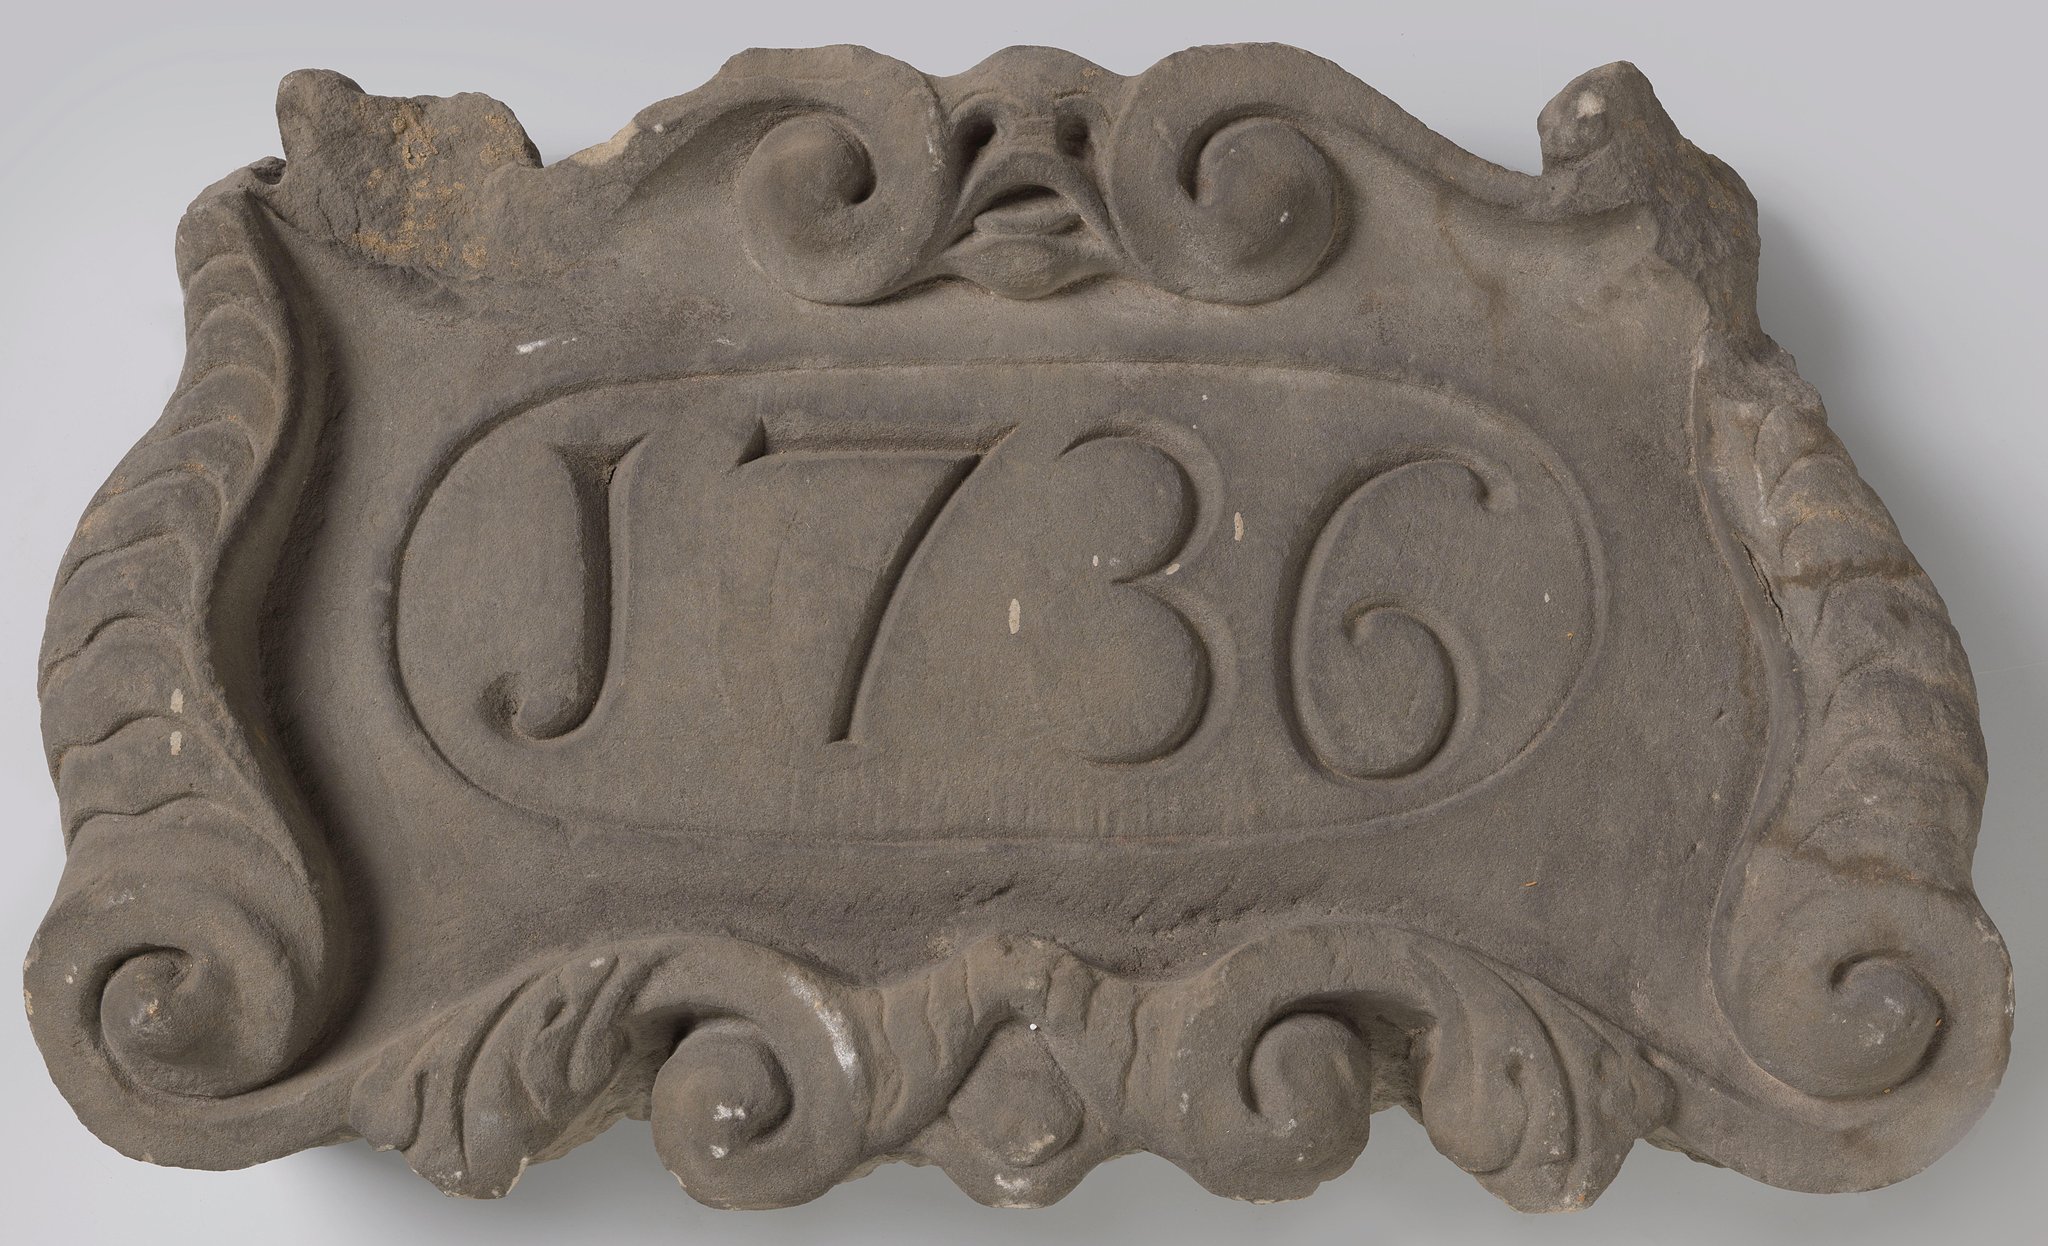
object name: gable stone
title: Gevelsteen met jaartal 1736.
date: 1736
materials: stone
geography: netherlands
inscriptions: date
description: Cartouche met krullen, voluten en acanthusbladeren, waarbinnen een ovaal waarbinnen het opschrift 1736. Deel linker- en rechter bovenhoek is afgebroken. Bij de steen horen twee stenen: KOG-ALS-149-1 met D Hollandse Hoedenmakerij en KOG-ALS-149-2 met ANNO.